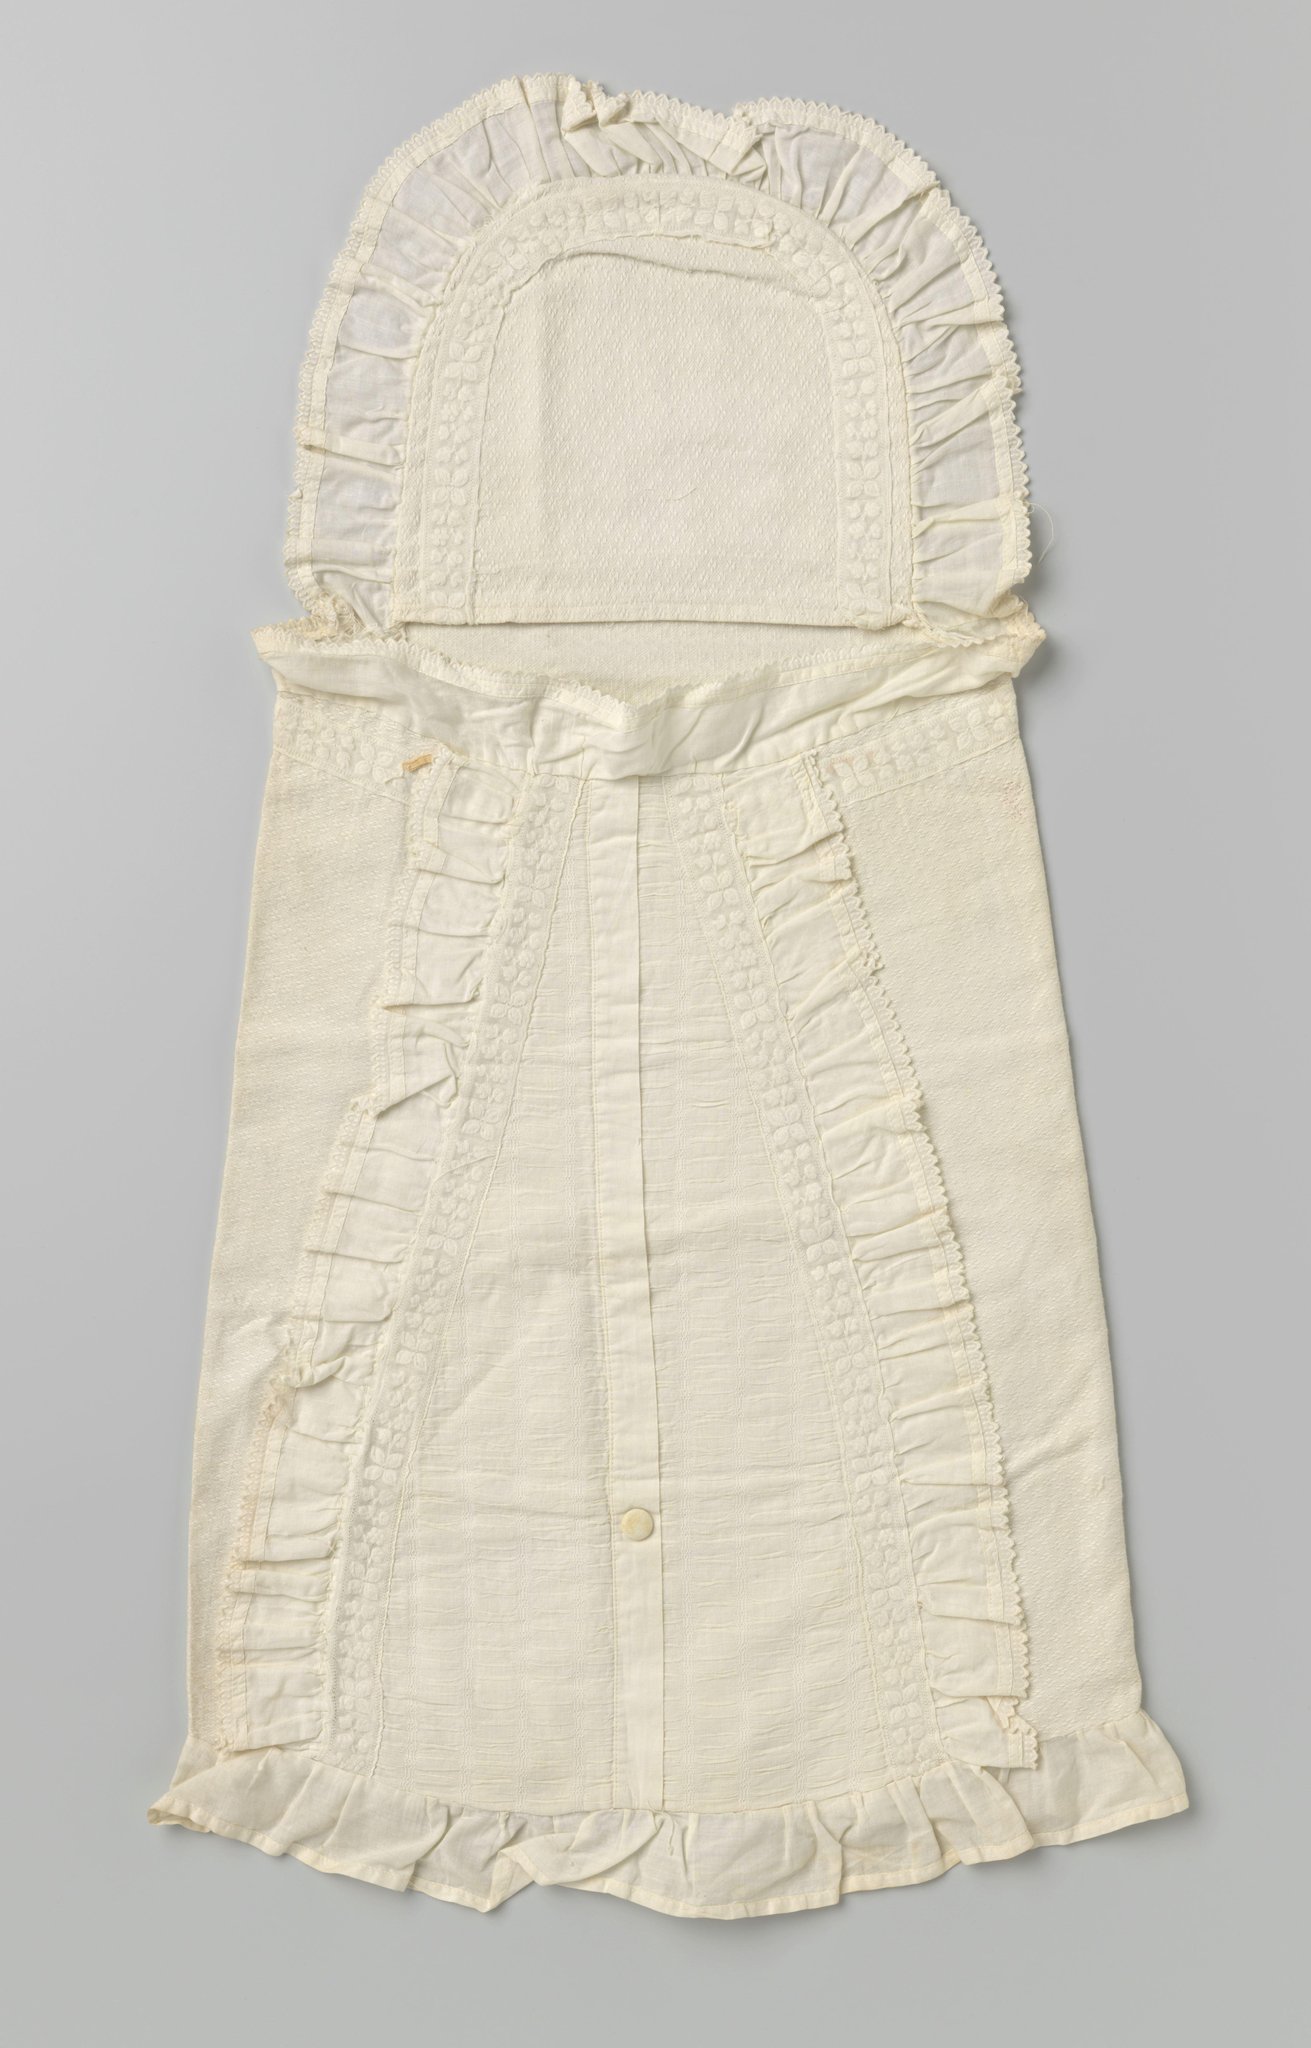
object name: doll's clothing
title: Overtrek van een draagkussen voor een pop, van katoen met machinaal borduurwerk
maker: Anonymous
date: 1880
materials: cotton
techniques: embroidered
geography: netherlands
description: Overtrek van een draagkussen voor een pop, van katoen met machinaal borduurwerk.